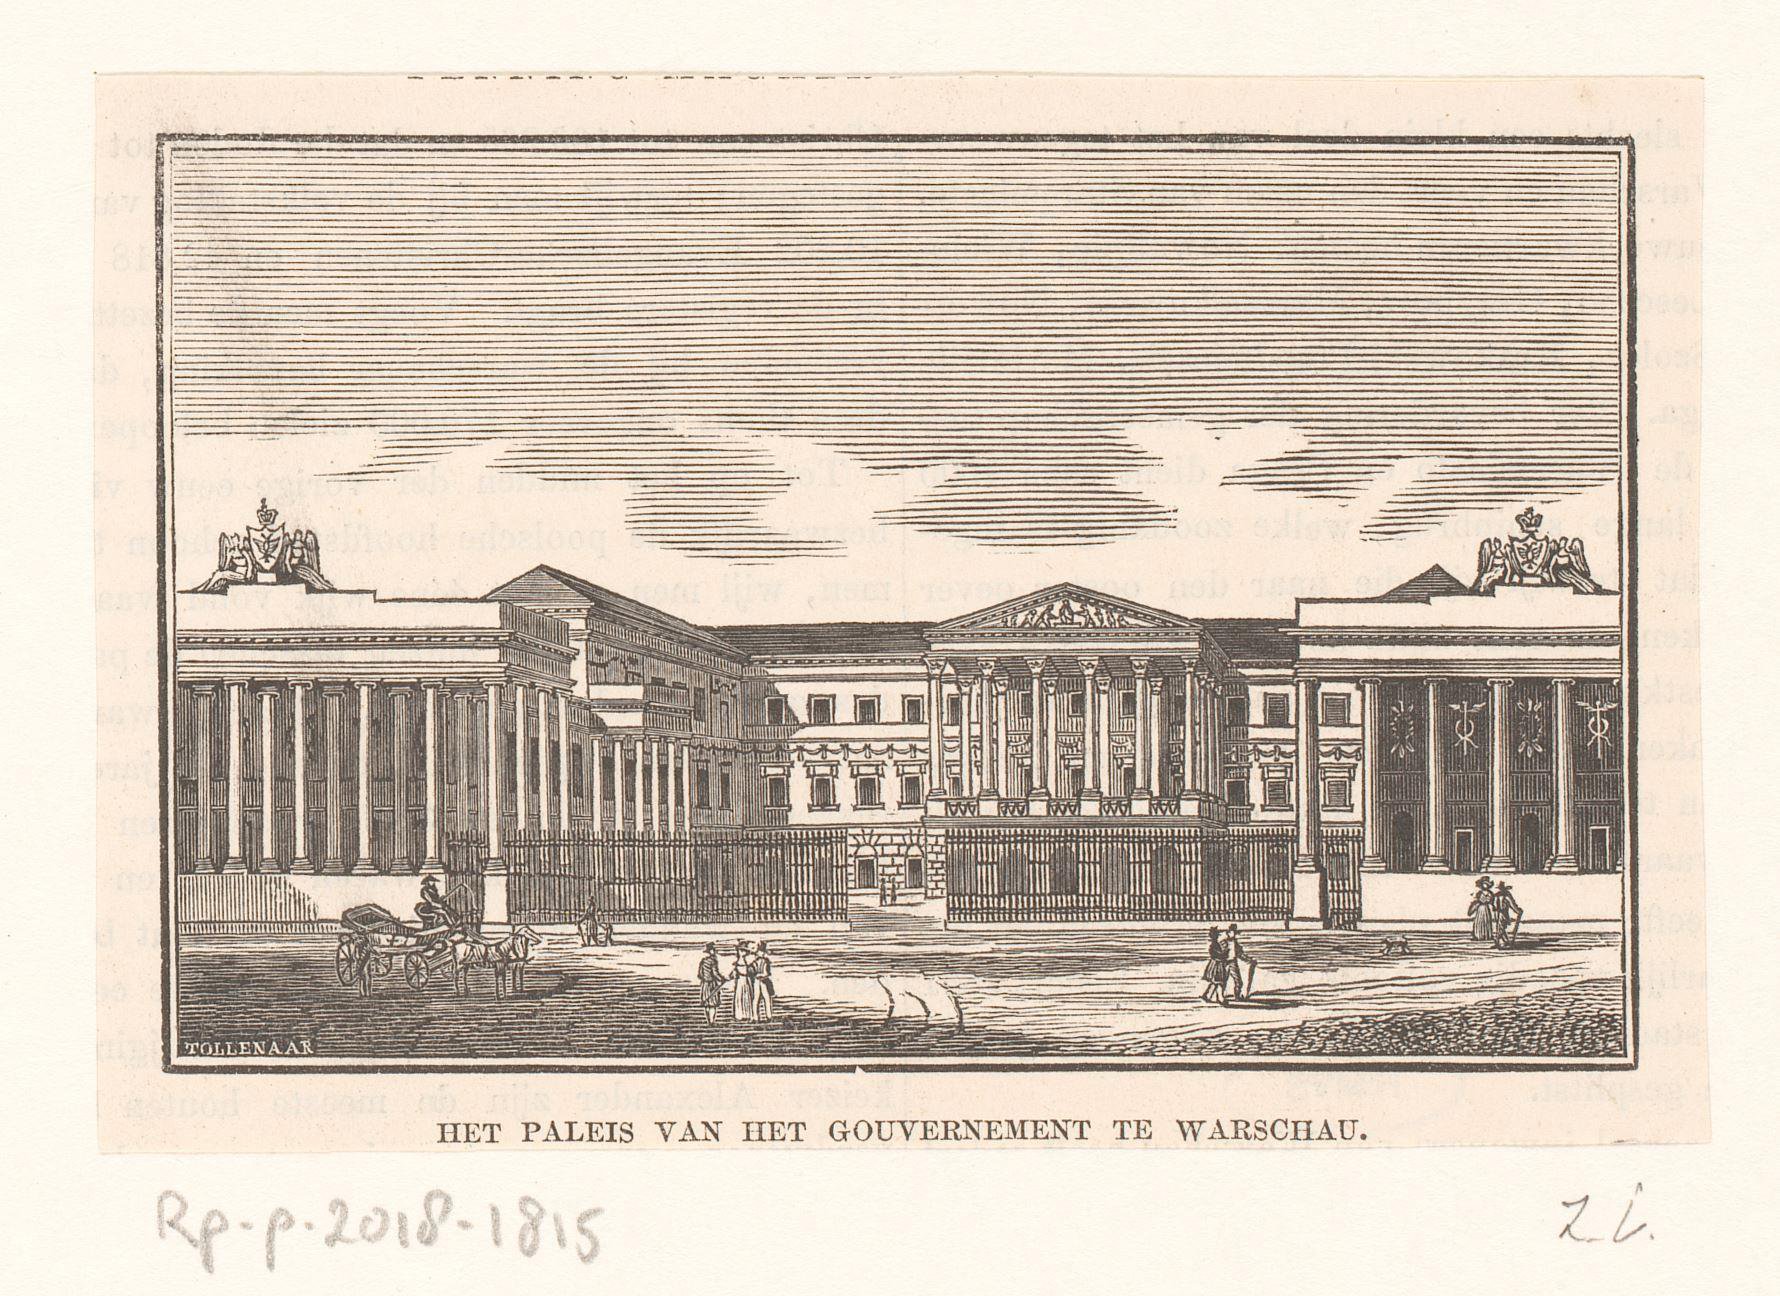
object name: print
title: Gezicht op het paleis van het Ministerie van Financiën, te Warschau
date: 1847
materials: paper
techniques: letterpress printing, engraving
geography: amsterdam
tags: palace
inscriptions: collector's mark: Lugt 2228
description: Prent gebruikt in: Witkamp, P.H. Beschrijving van Oost- en Noord-Europa. Amsterdam: J.H. Laarman, 1847.